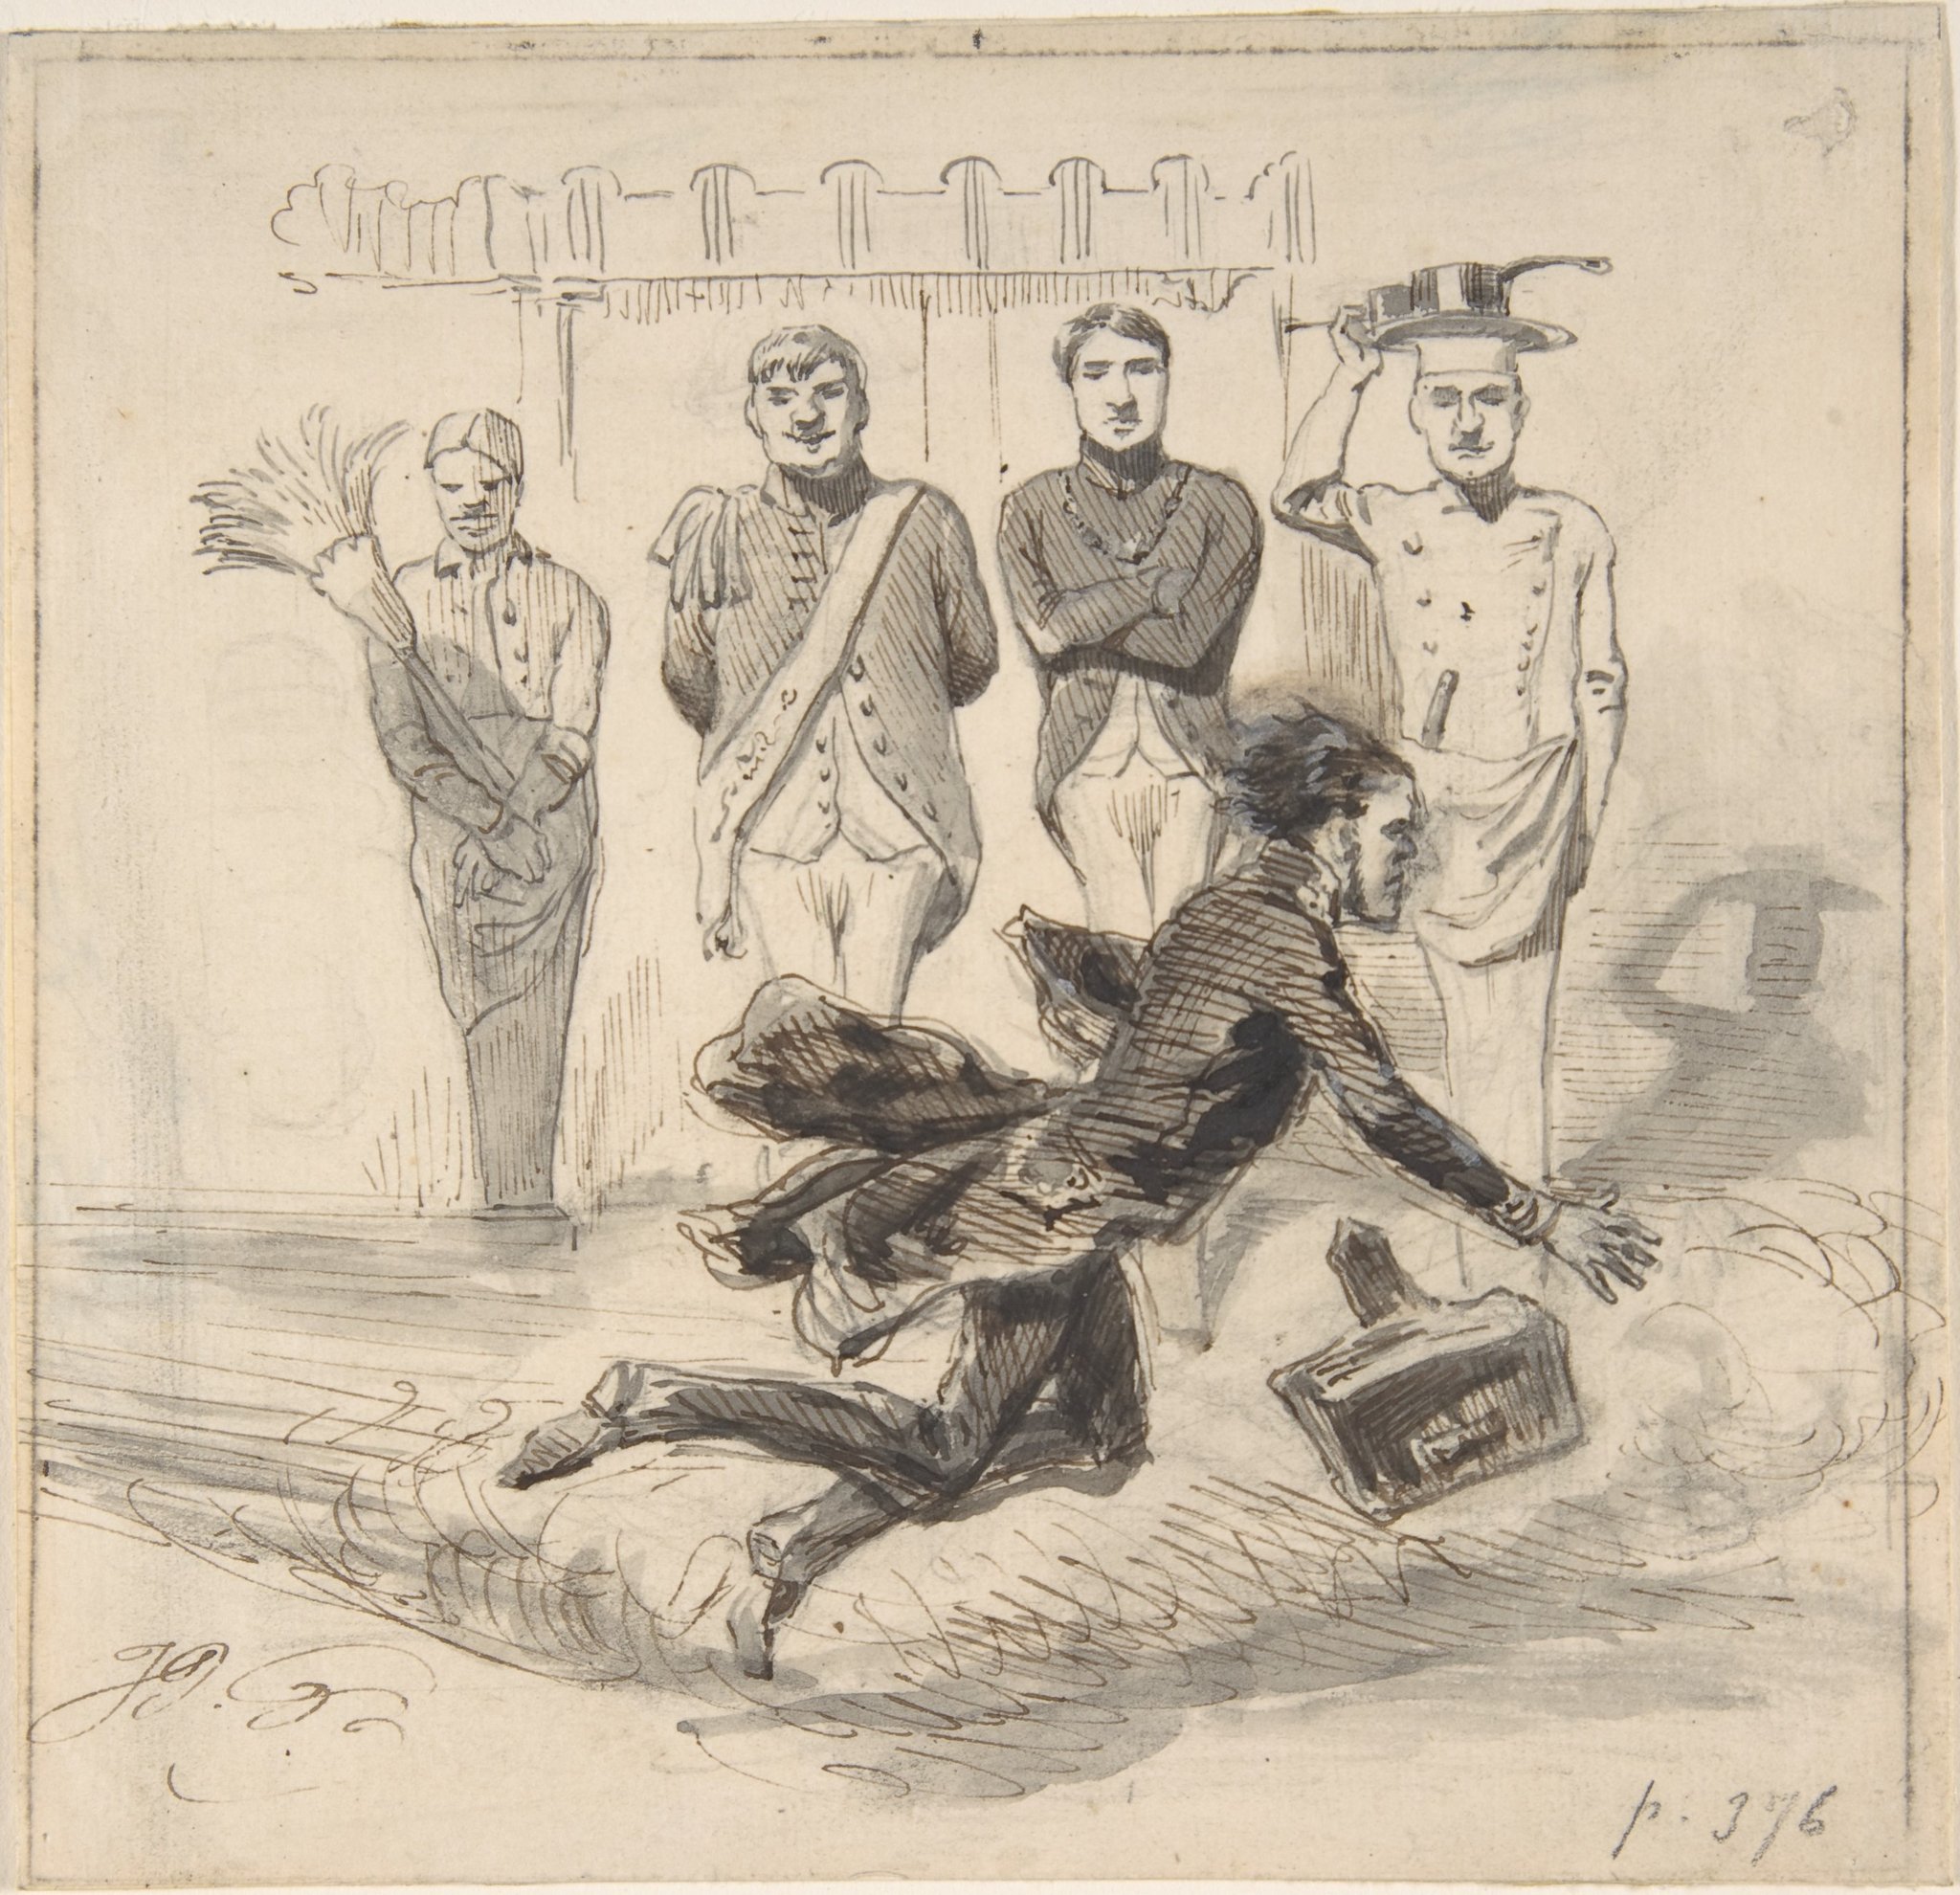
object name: drawing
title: Illustration in Jérôme Paturot, by Louis Reybaud, Paris, 1846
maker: j. j. grandville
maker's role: artist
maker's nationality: french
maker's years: 1803-1847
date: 1846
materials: graphite, ink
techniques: brush, pen, wash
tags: men